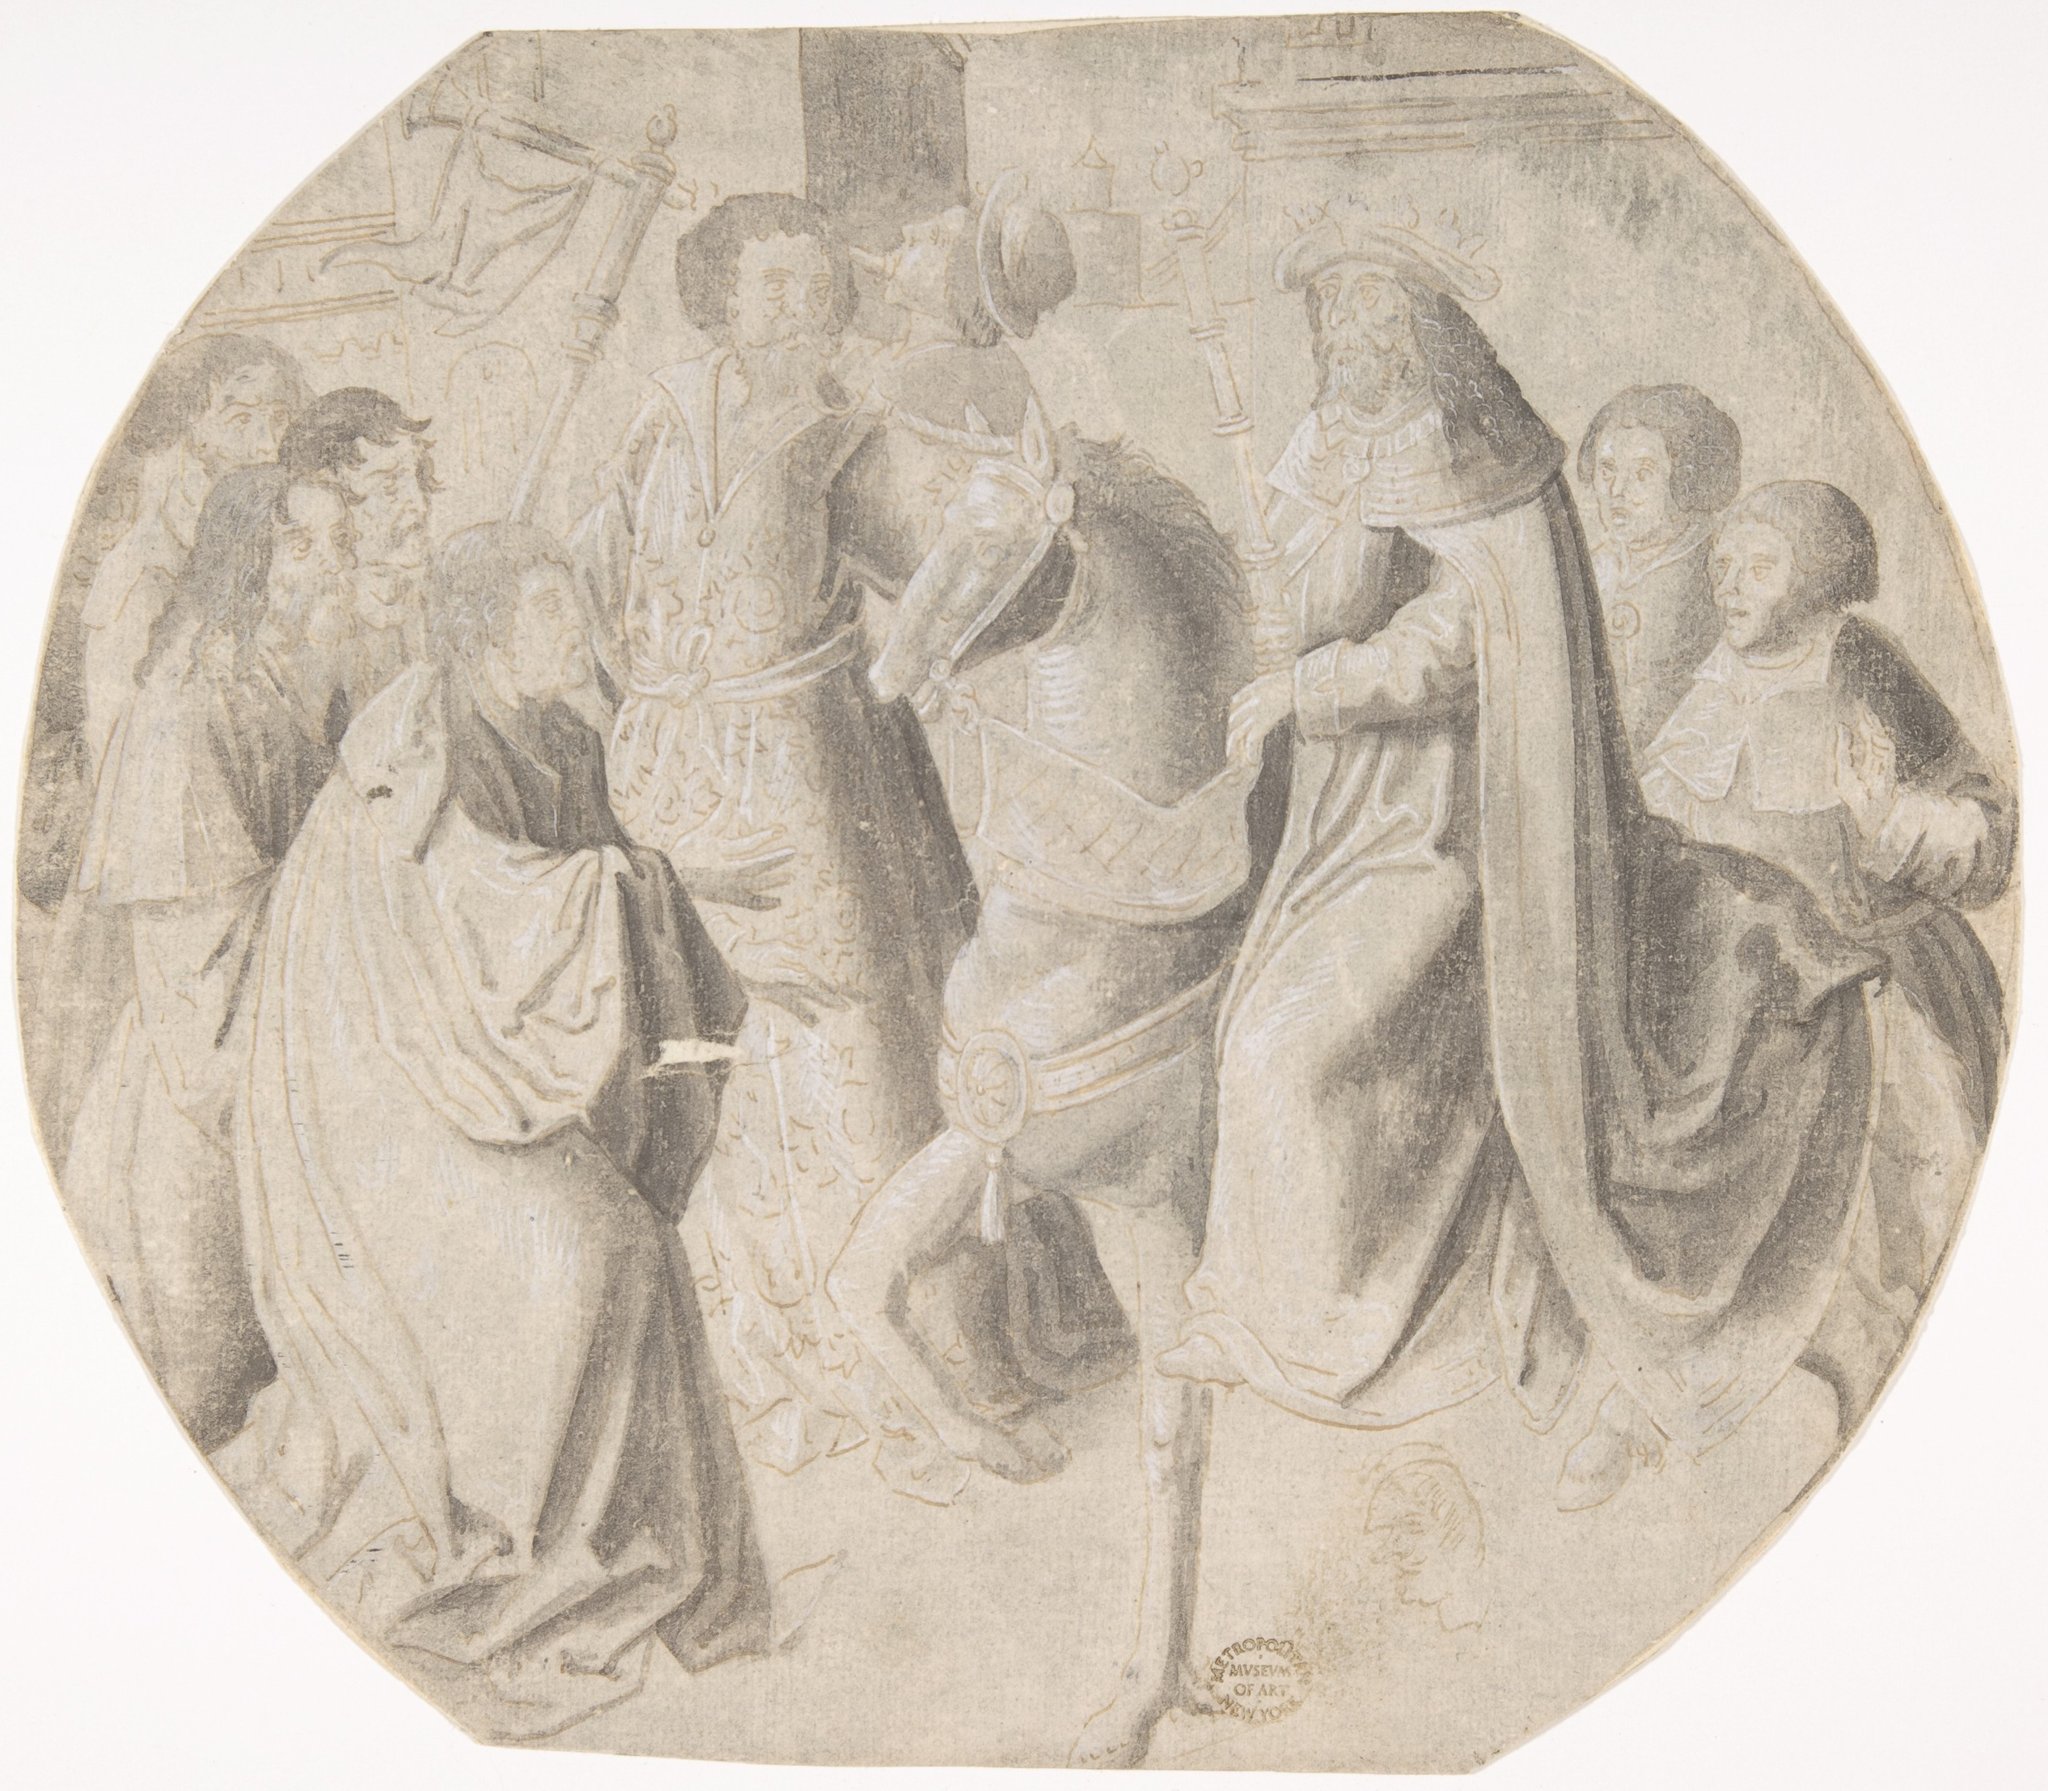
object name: drawing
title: Mordecai rides through the Streets in the Apparel the King has sent him.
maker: pseudo-aert ortkens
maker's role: artist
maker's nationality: netherlandish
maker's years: 1510-1540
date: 1501-1566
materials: ink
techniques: brush, highlighting, pen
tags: streets,kings,men,women,horses